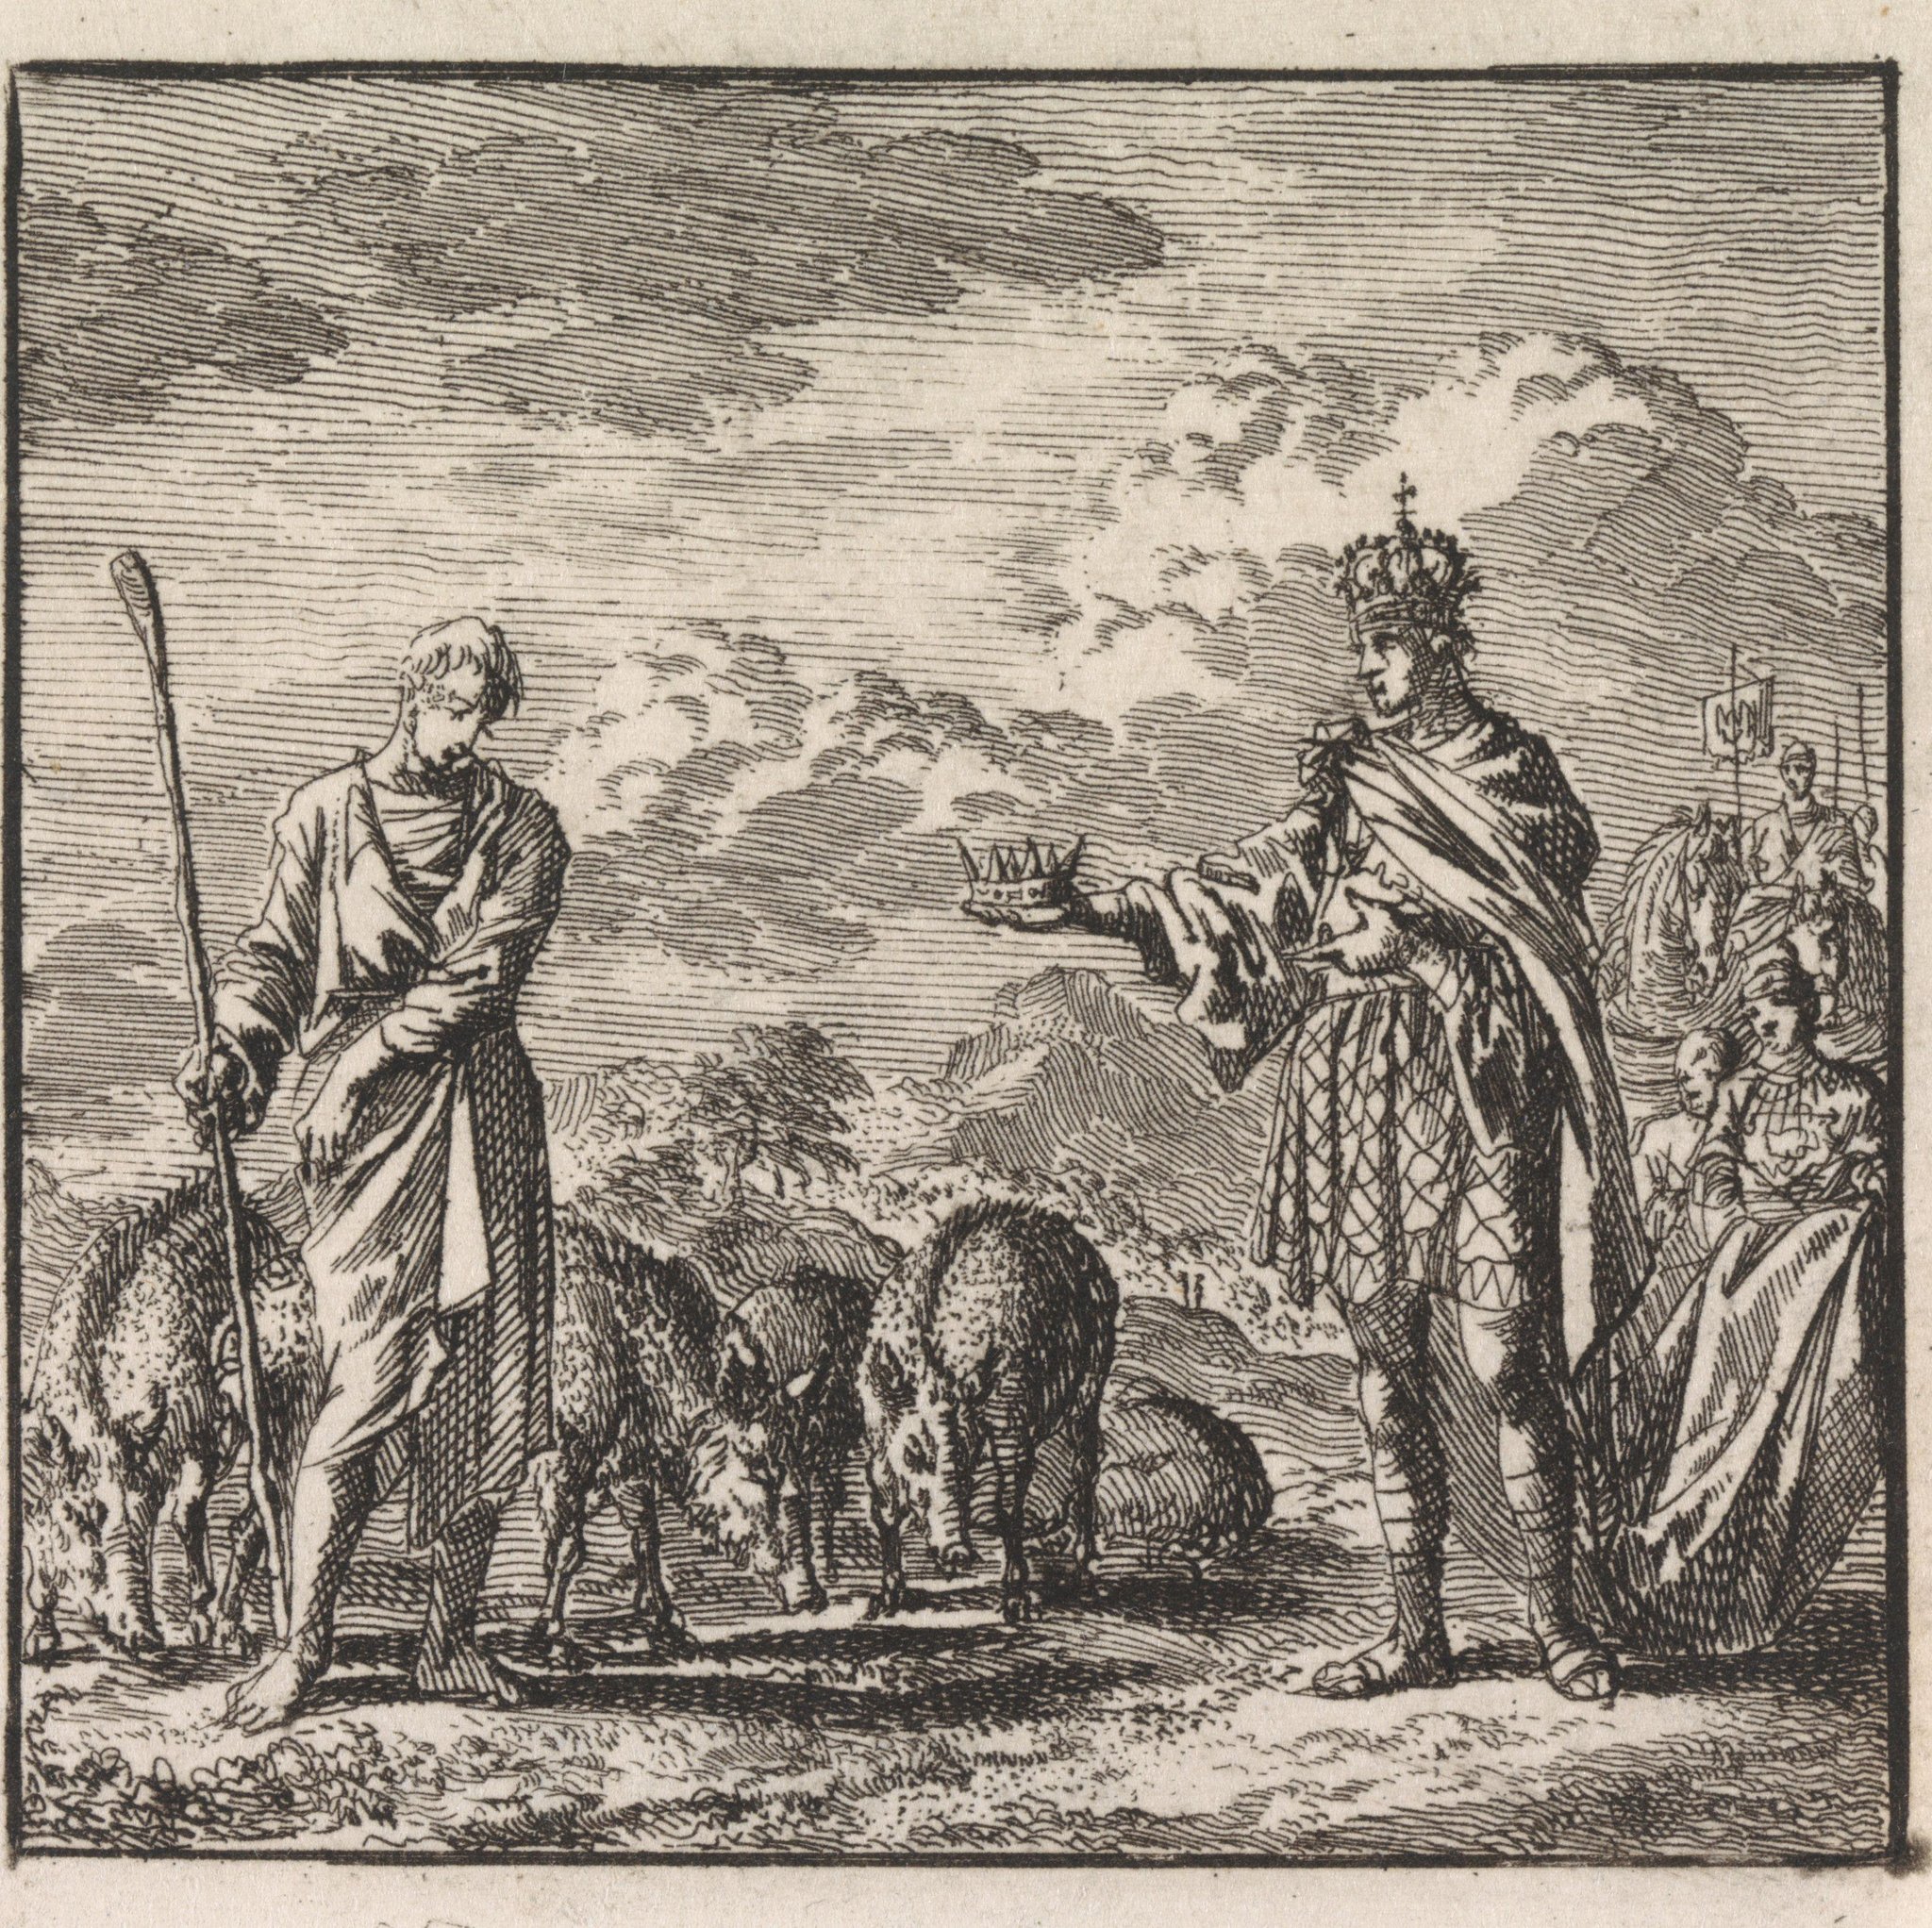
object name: print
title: Zwijnenboer wijgert de kroon die hem wordt aangeboeden door een koning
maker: jan luyken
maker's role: draughtsman, print maker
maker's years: 1649-1712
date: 1710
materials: paper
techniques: etching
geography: amsterdam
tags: crown (symbol of sovereignty), pig, ruler, sovereign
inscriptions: collector's mark: Lugt 2228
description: Proefdruk voor llustratie uit: Luyken, Jan. De onwaardige wereld, vertoond in vyftig zinnebeelden, met godlyke spreuken en stichtelyke verzen. Amsterdam: Pieter Arentsz. II (wed.) en Cornelis van der Sys, 1710, p. 102.